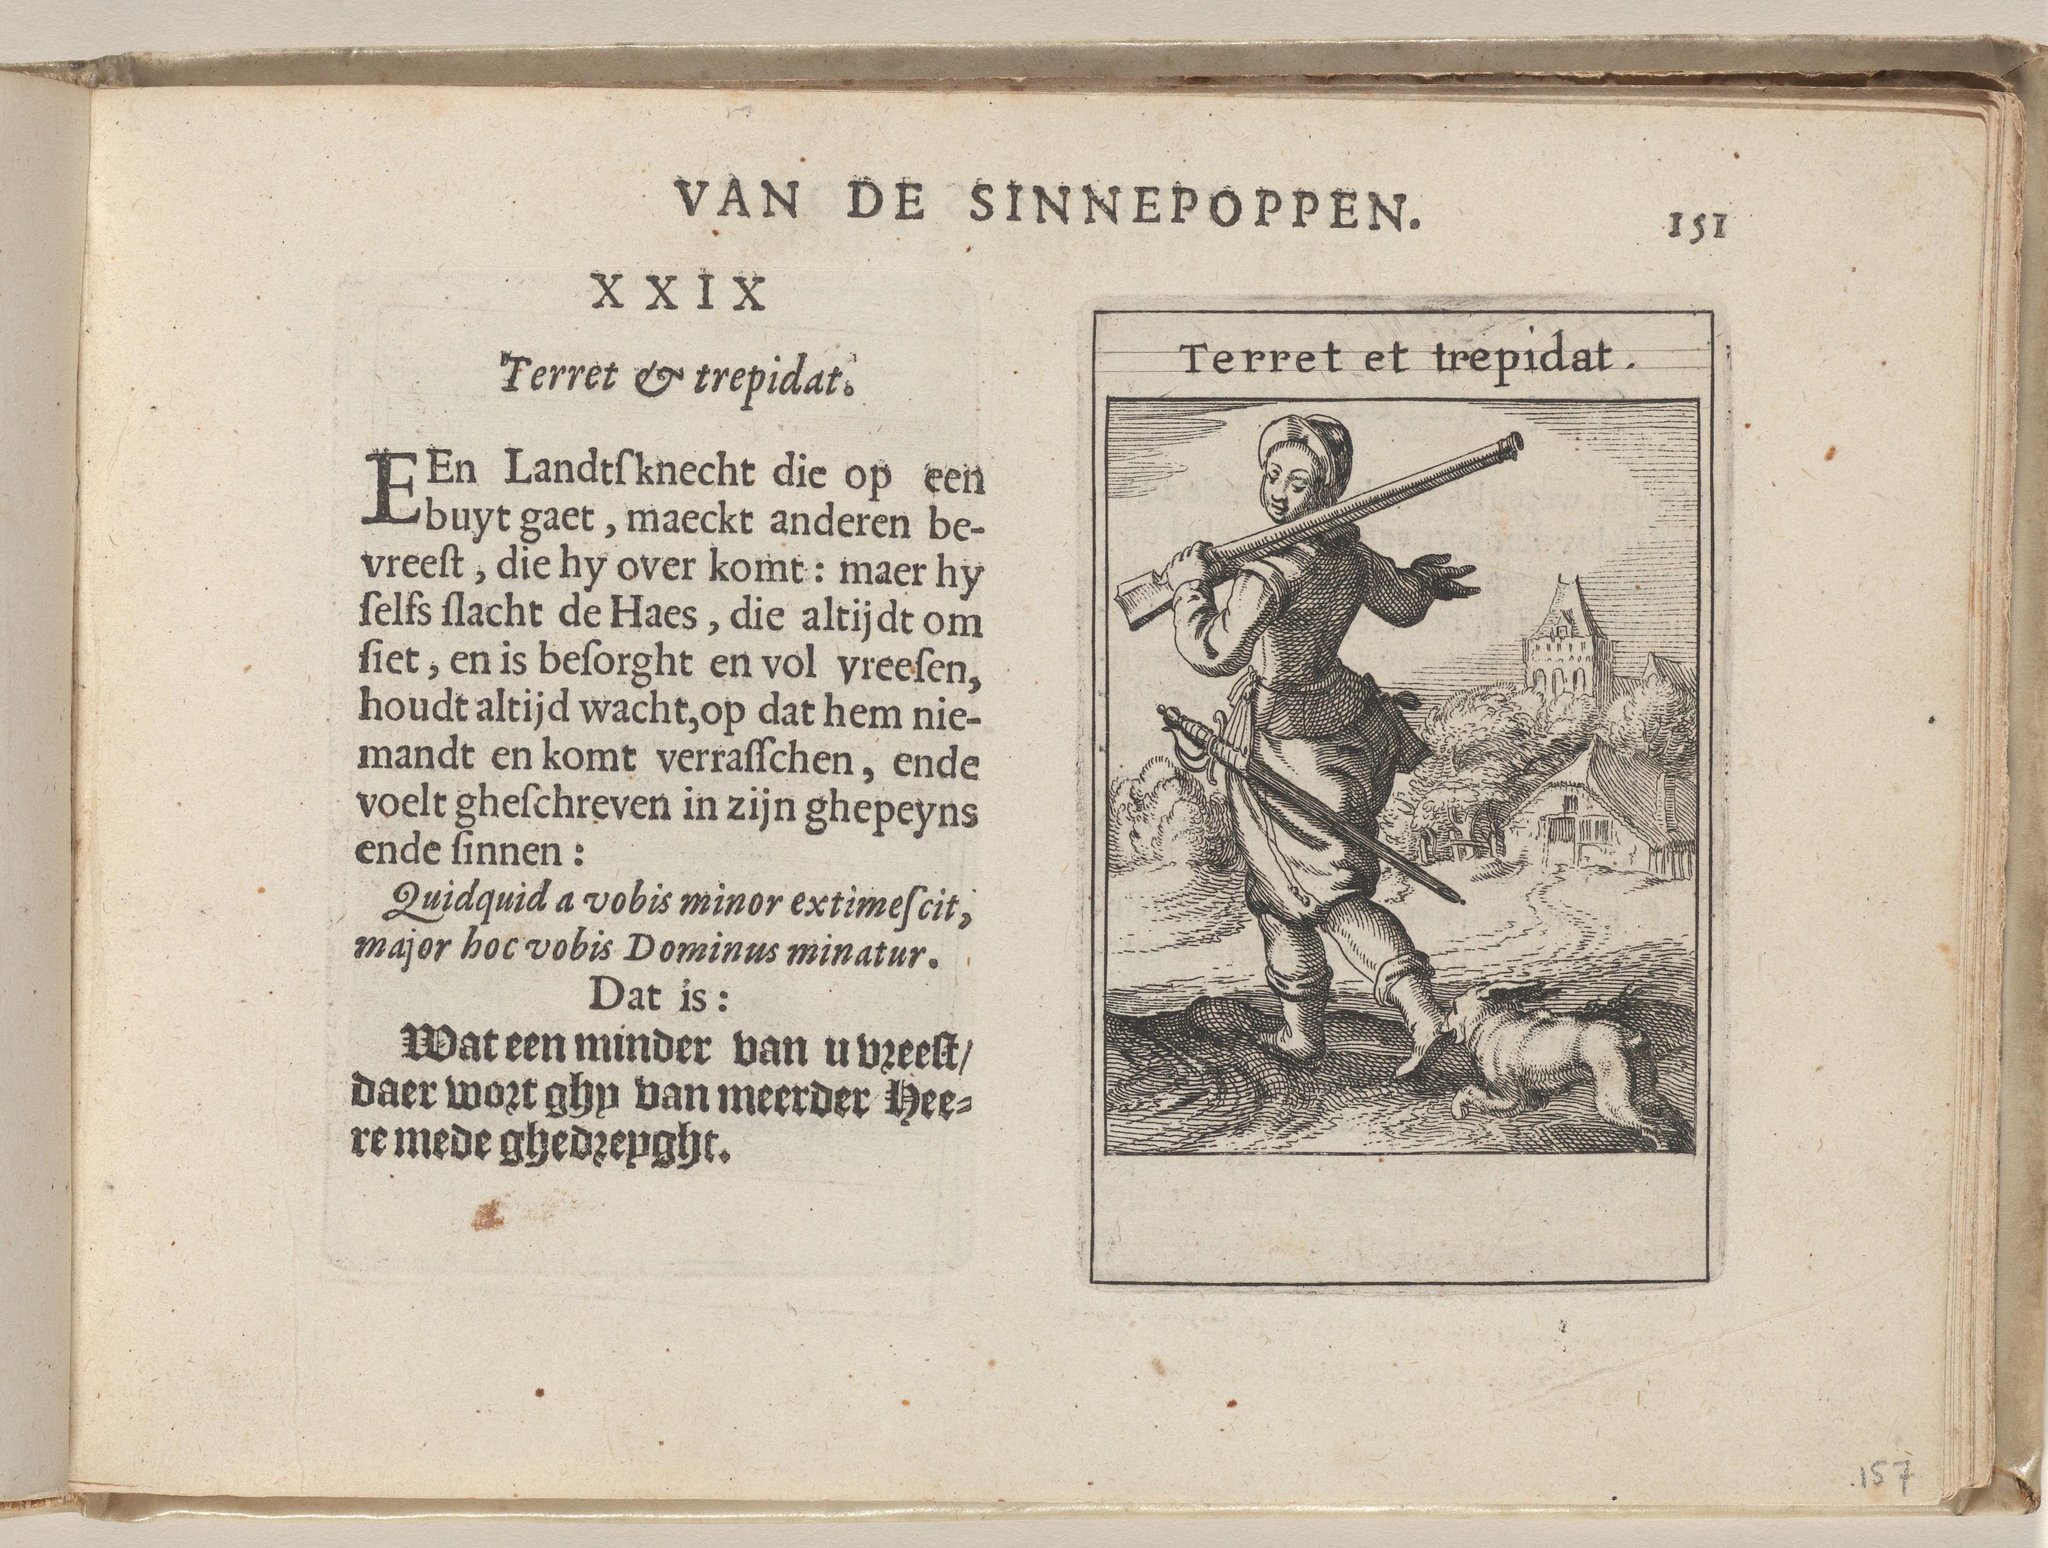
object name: print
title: XXIX Terret et trepidat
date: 1614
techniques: engraving, printing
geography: amsterdam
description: XXIX Terret et trepidat. Derde schok. Onderdeel van 'Sinnepoppen', R. Visscher, 1614.